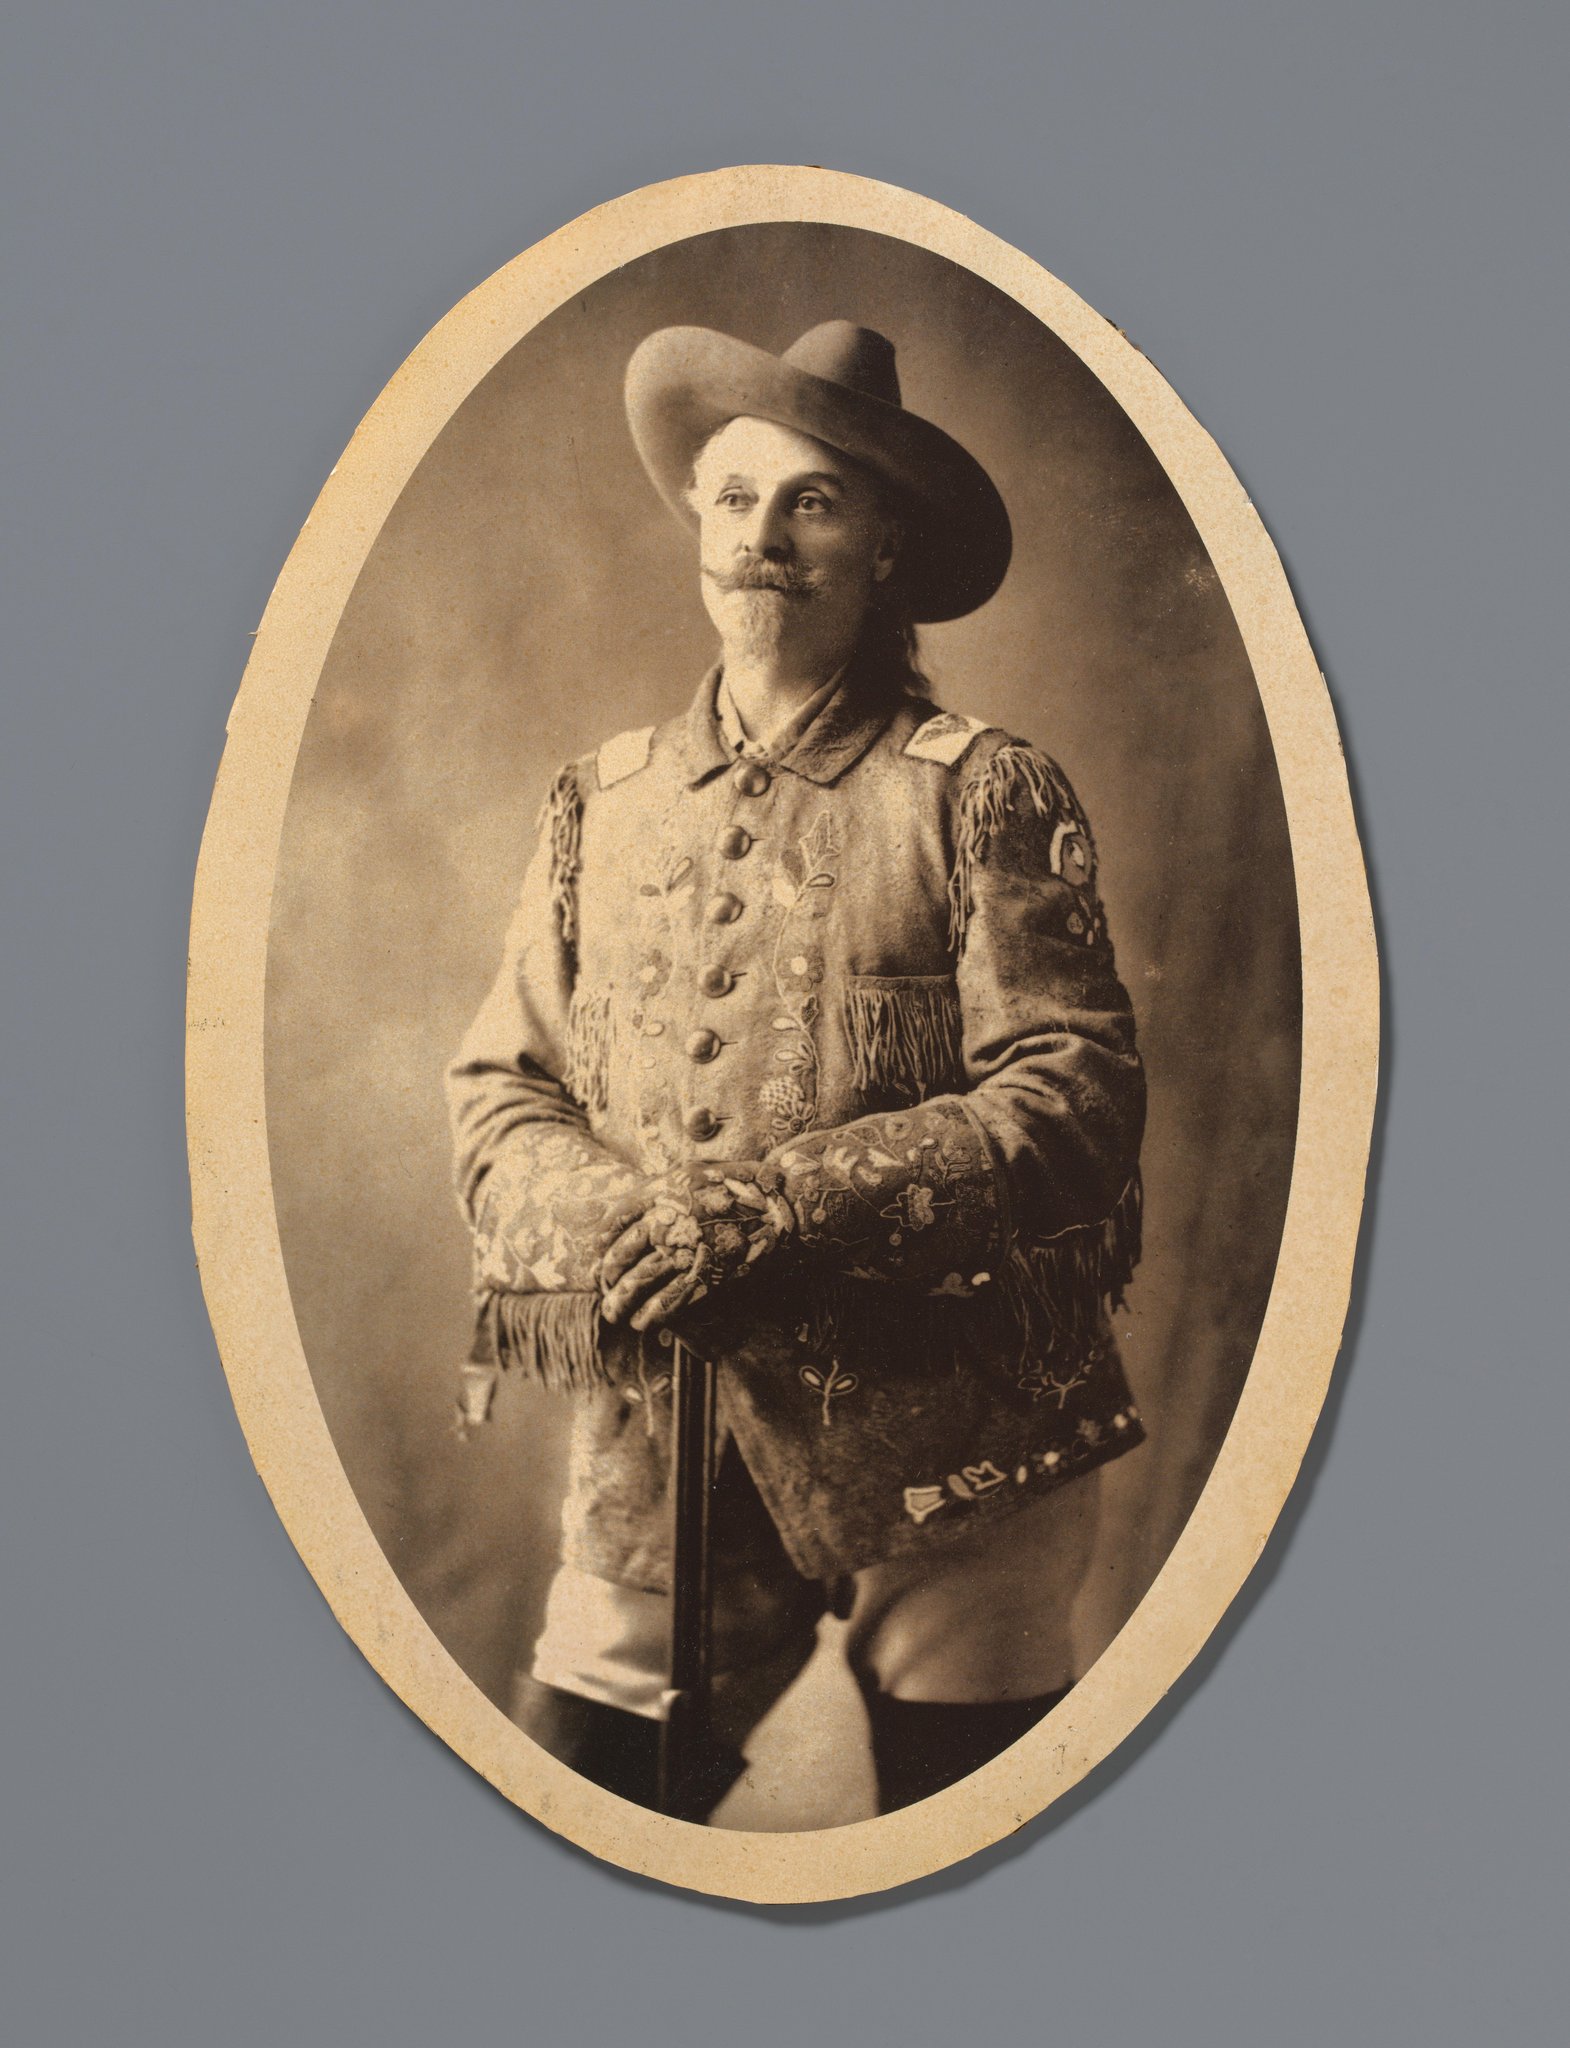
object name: frame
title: Portret van Buffalo Bill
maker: Anonymous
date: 1890-1930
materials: cardboard, paper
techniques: autotype, color photography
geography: united states